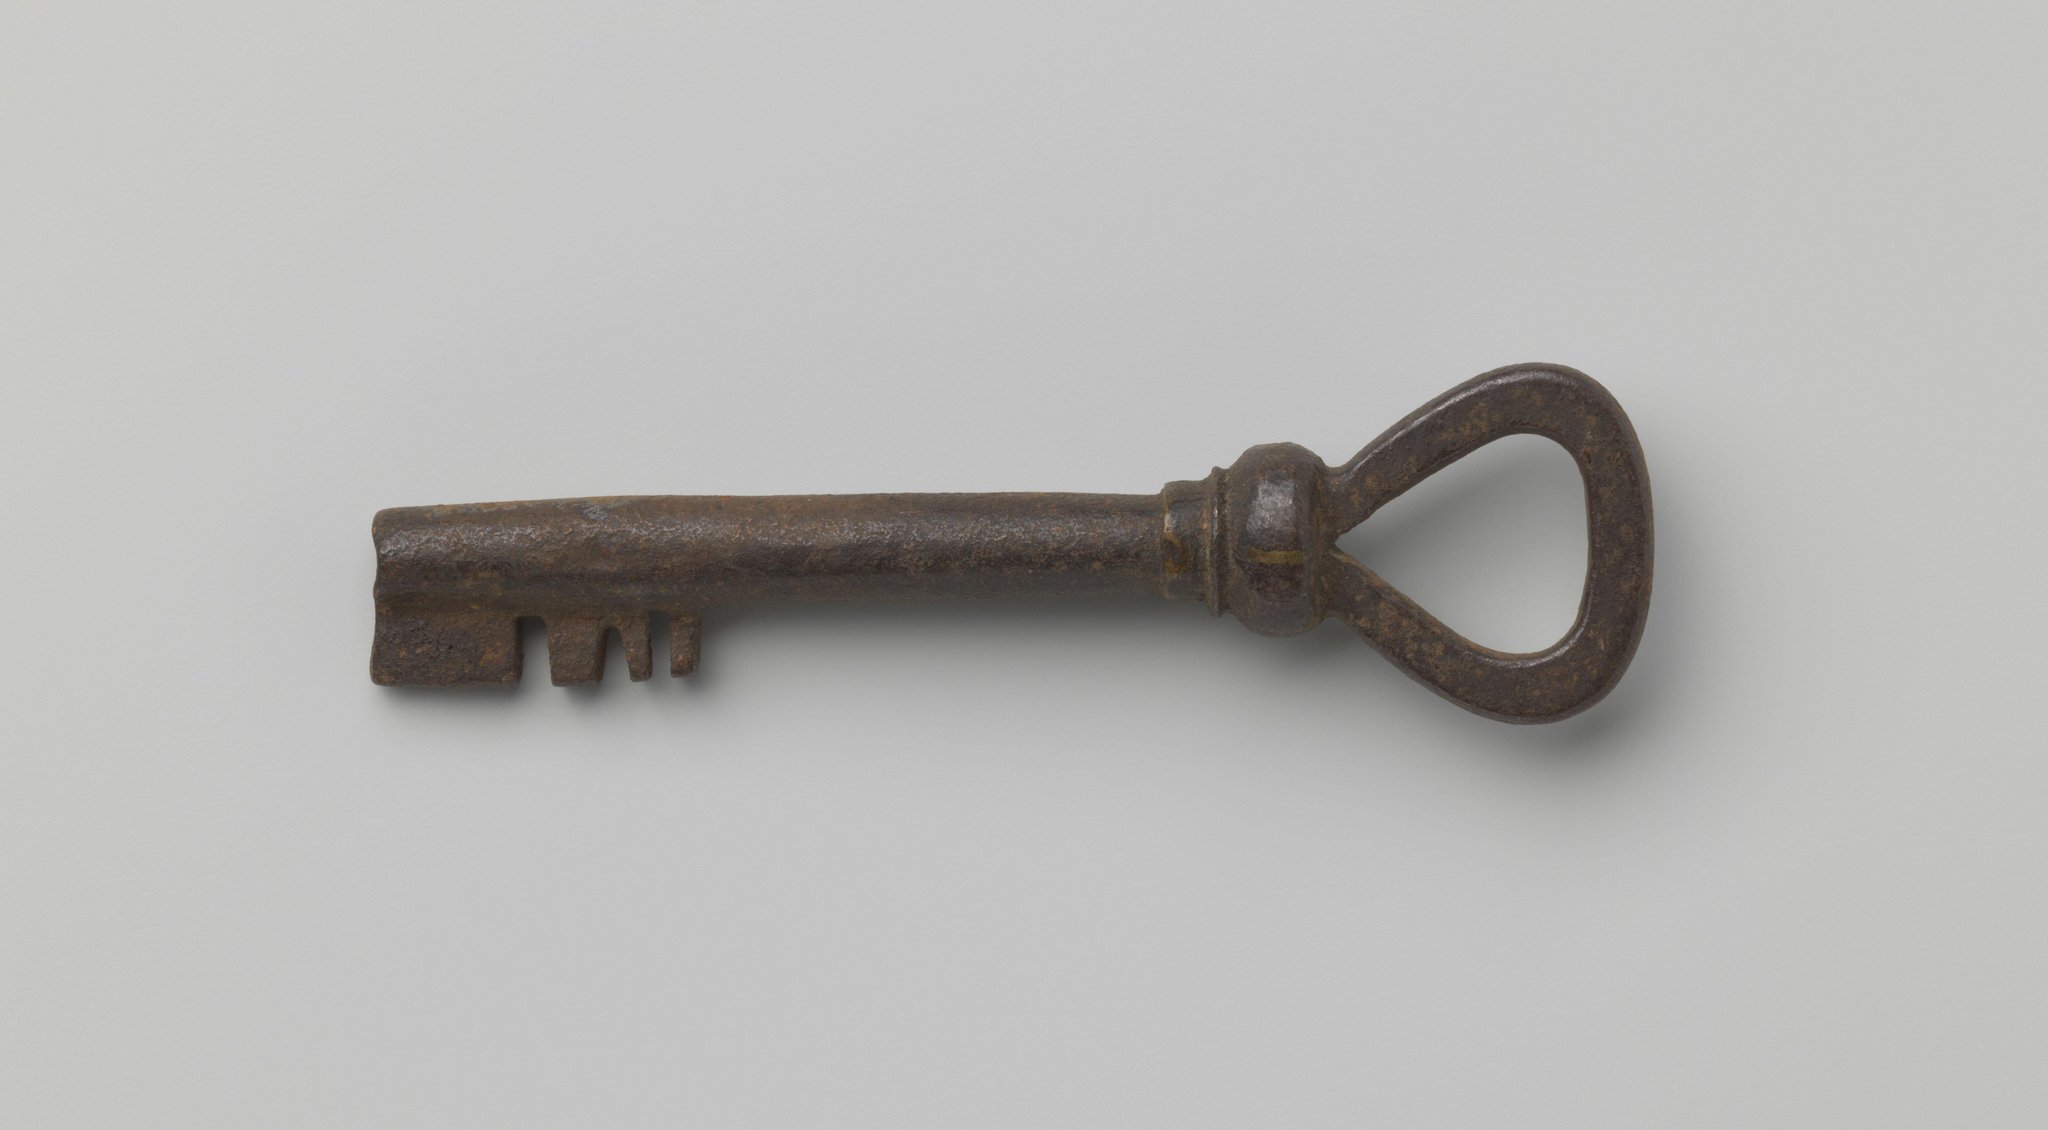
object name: key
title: Sleutel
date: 1400-1950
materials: iron